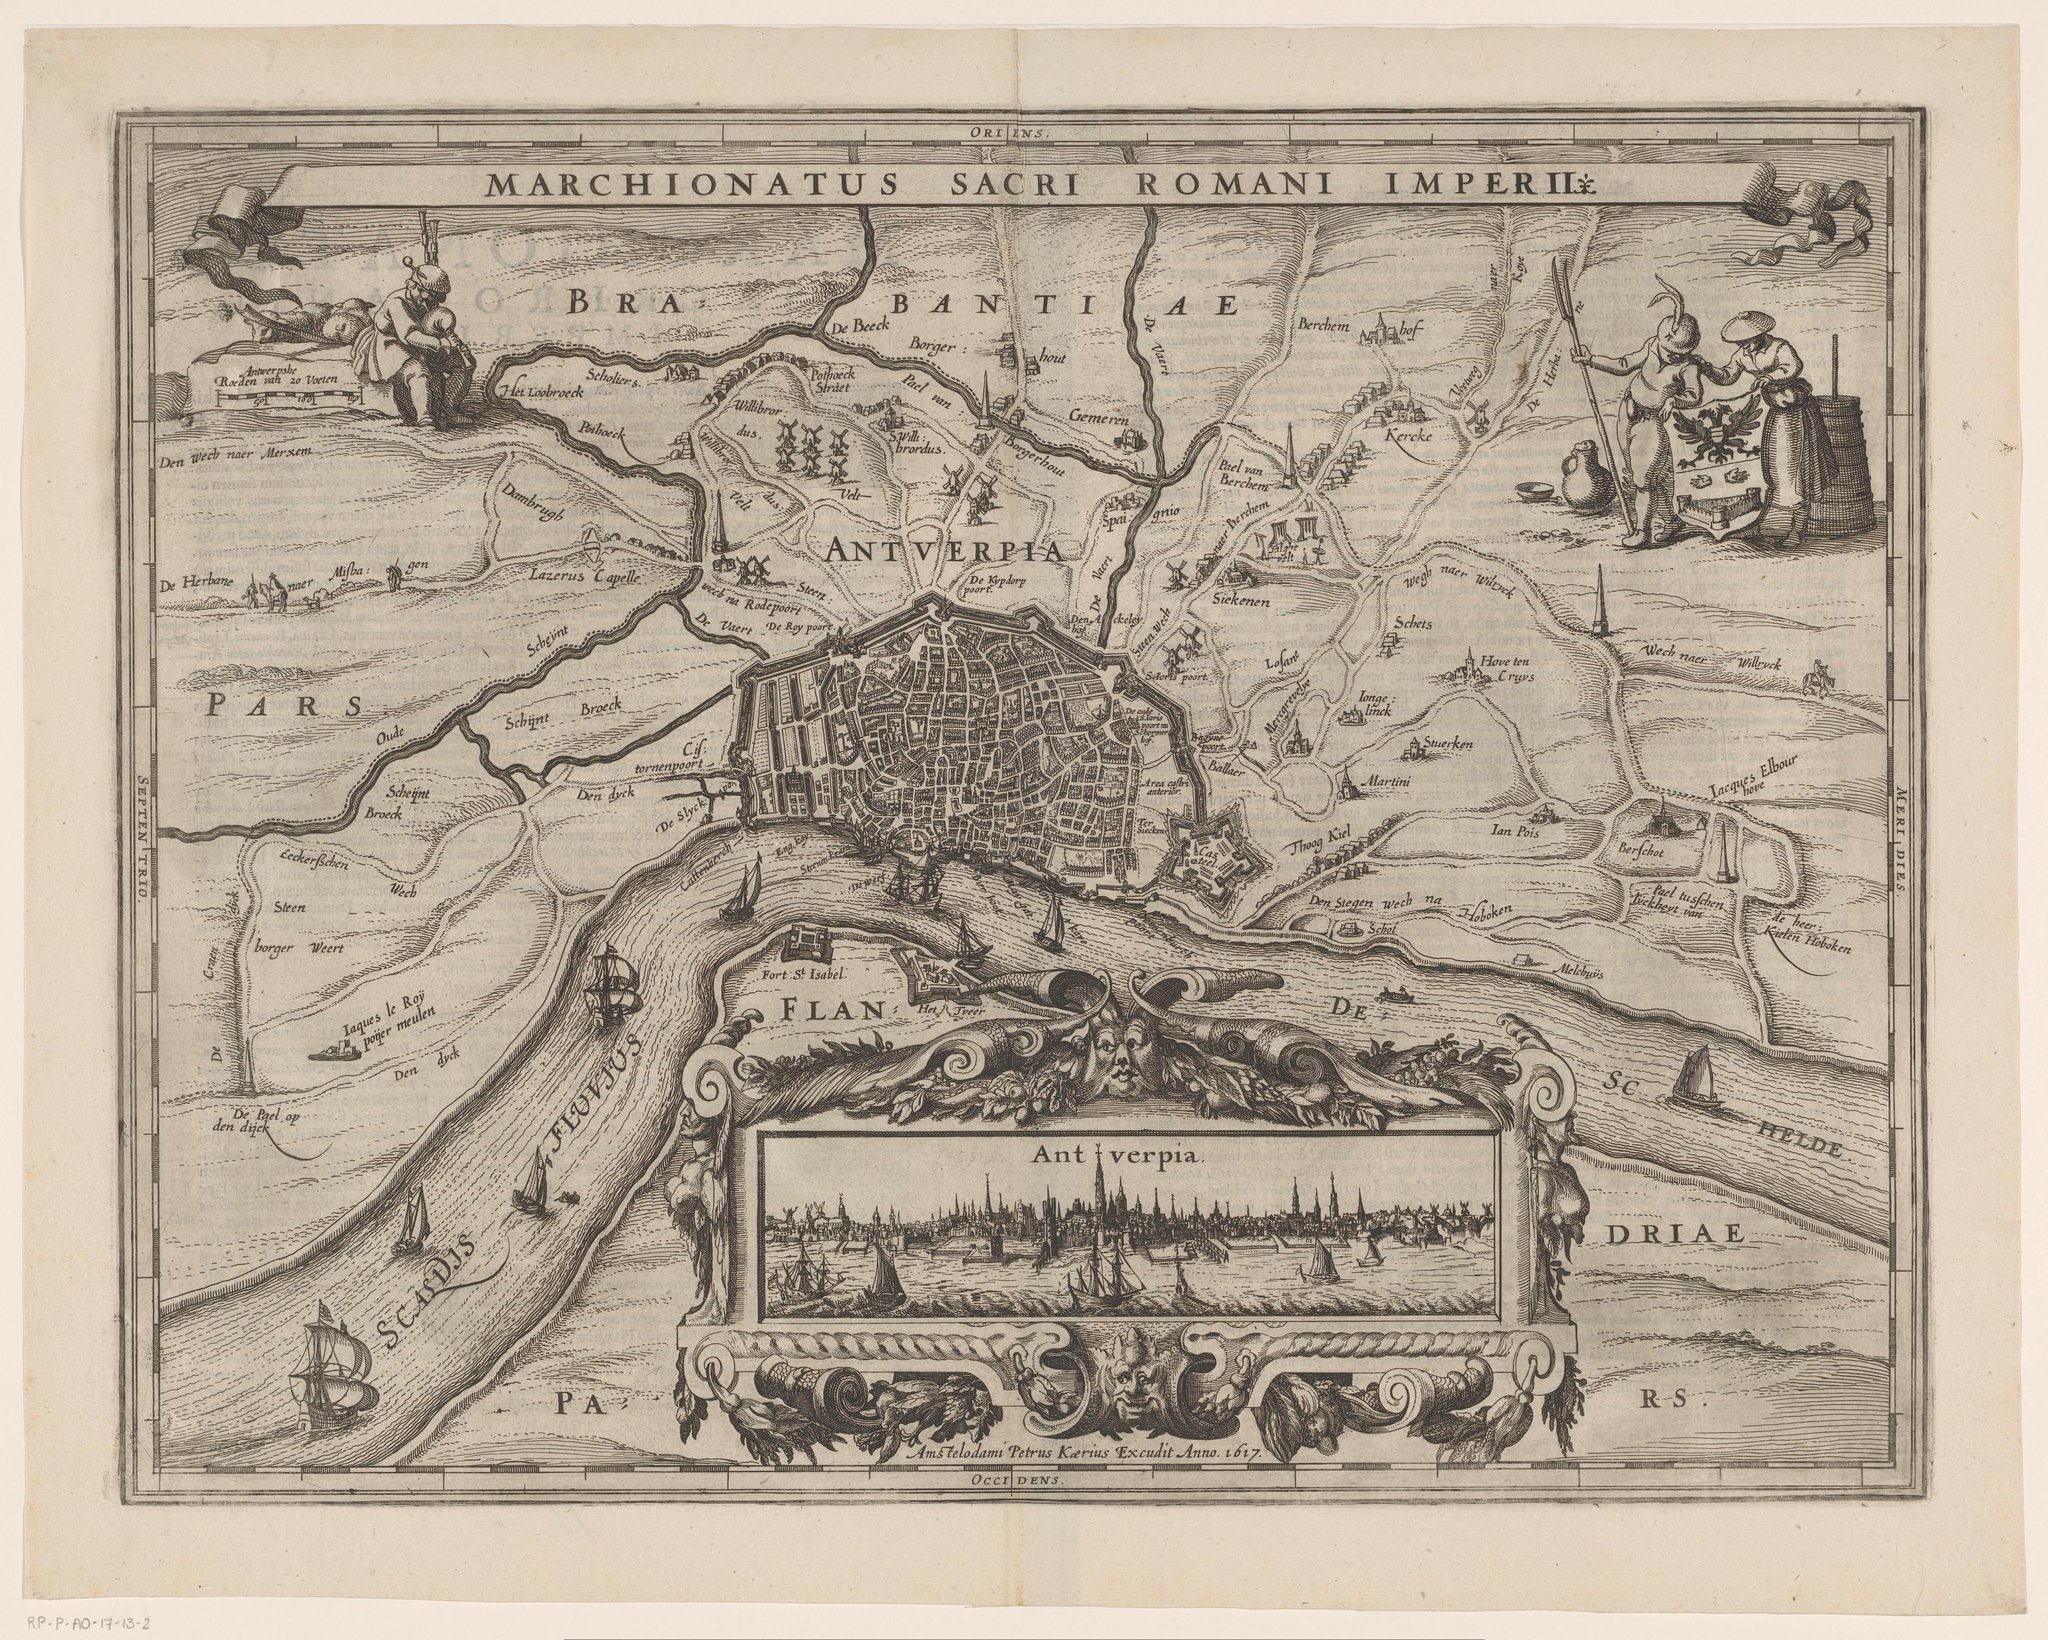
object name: print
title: Plattegrond van Antwerpen met stadsgezicht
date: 1617-1622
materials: paper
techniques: engraving, etching, letterpress printing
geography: amsterdam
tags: coat of arms (as symbol of the state, etc.) (+ city; municipal), bagpipe, musette, farmers, maps of cities, prospect of city, town panorama, silhouette of city, antwerp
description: Prent gebruikt in: Keere, Pieter van der. Germania inferior id est, provinciarum ejus novae et exactae tabulae geographicae. 1e druk. Amsterdam: Pieter van der Keere, 1617. Of in: Keere, Pieter van der. Germania inferior id est, provinciarum ejus novae et exactae tabulae geographicae. 2e druk. Amsterdam: Pieter van der Keere, 1622.